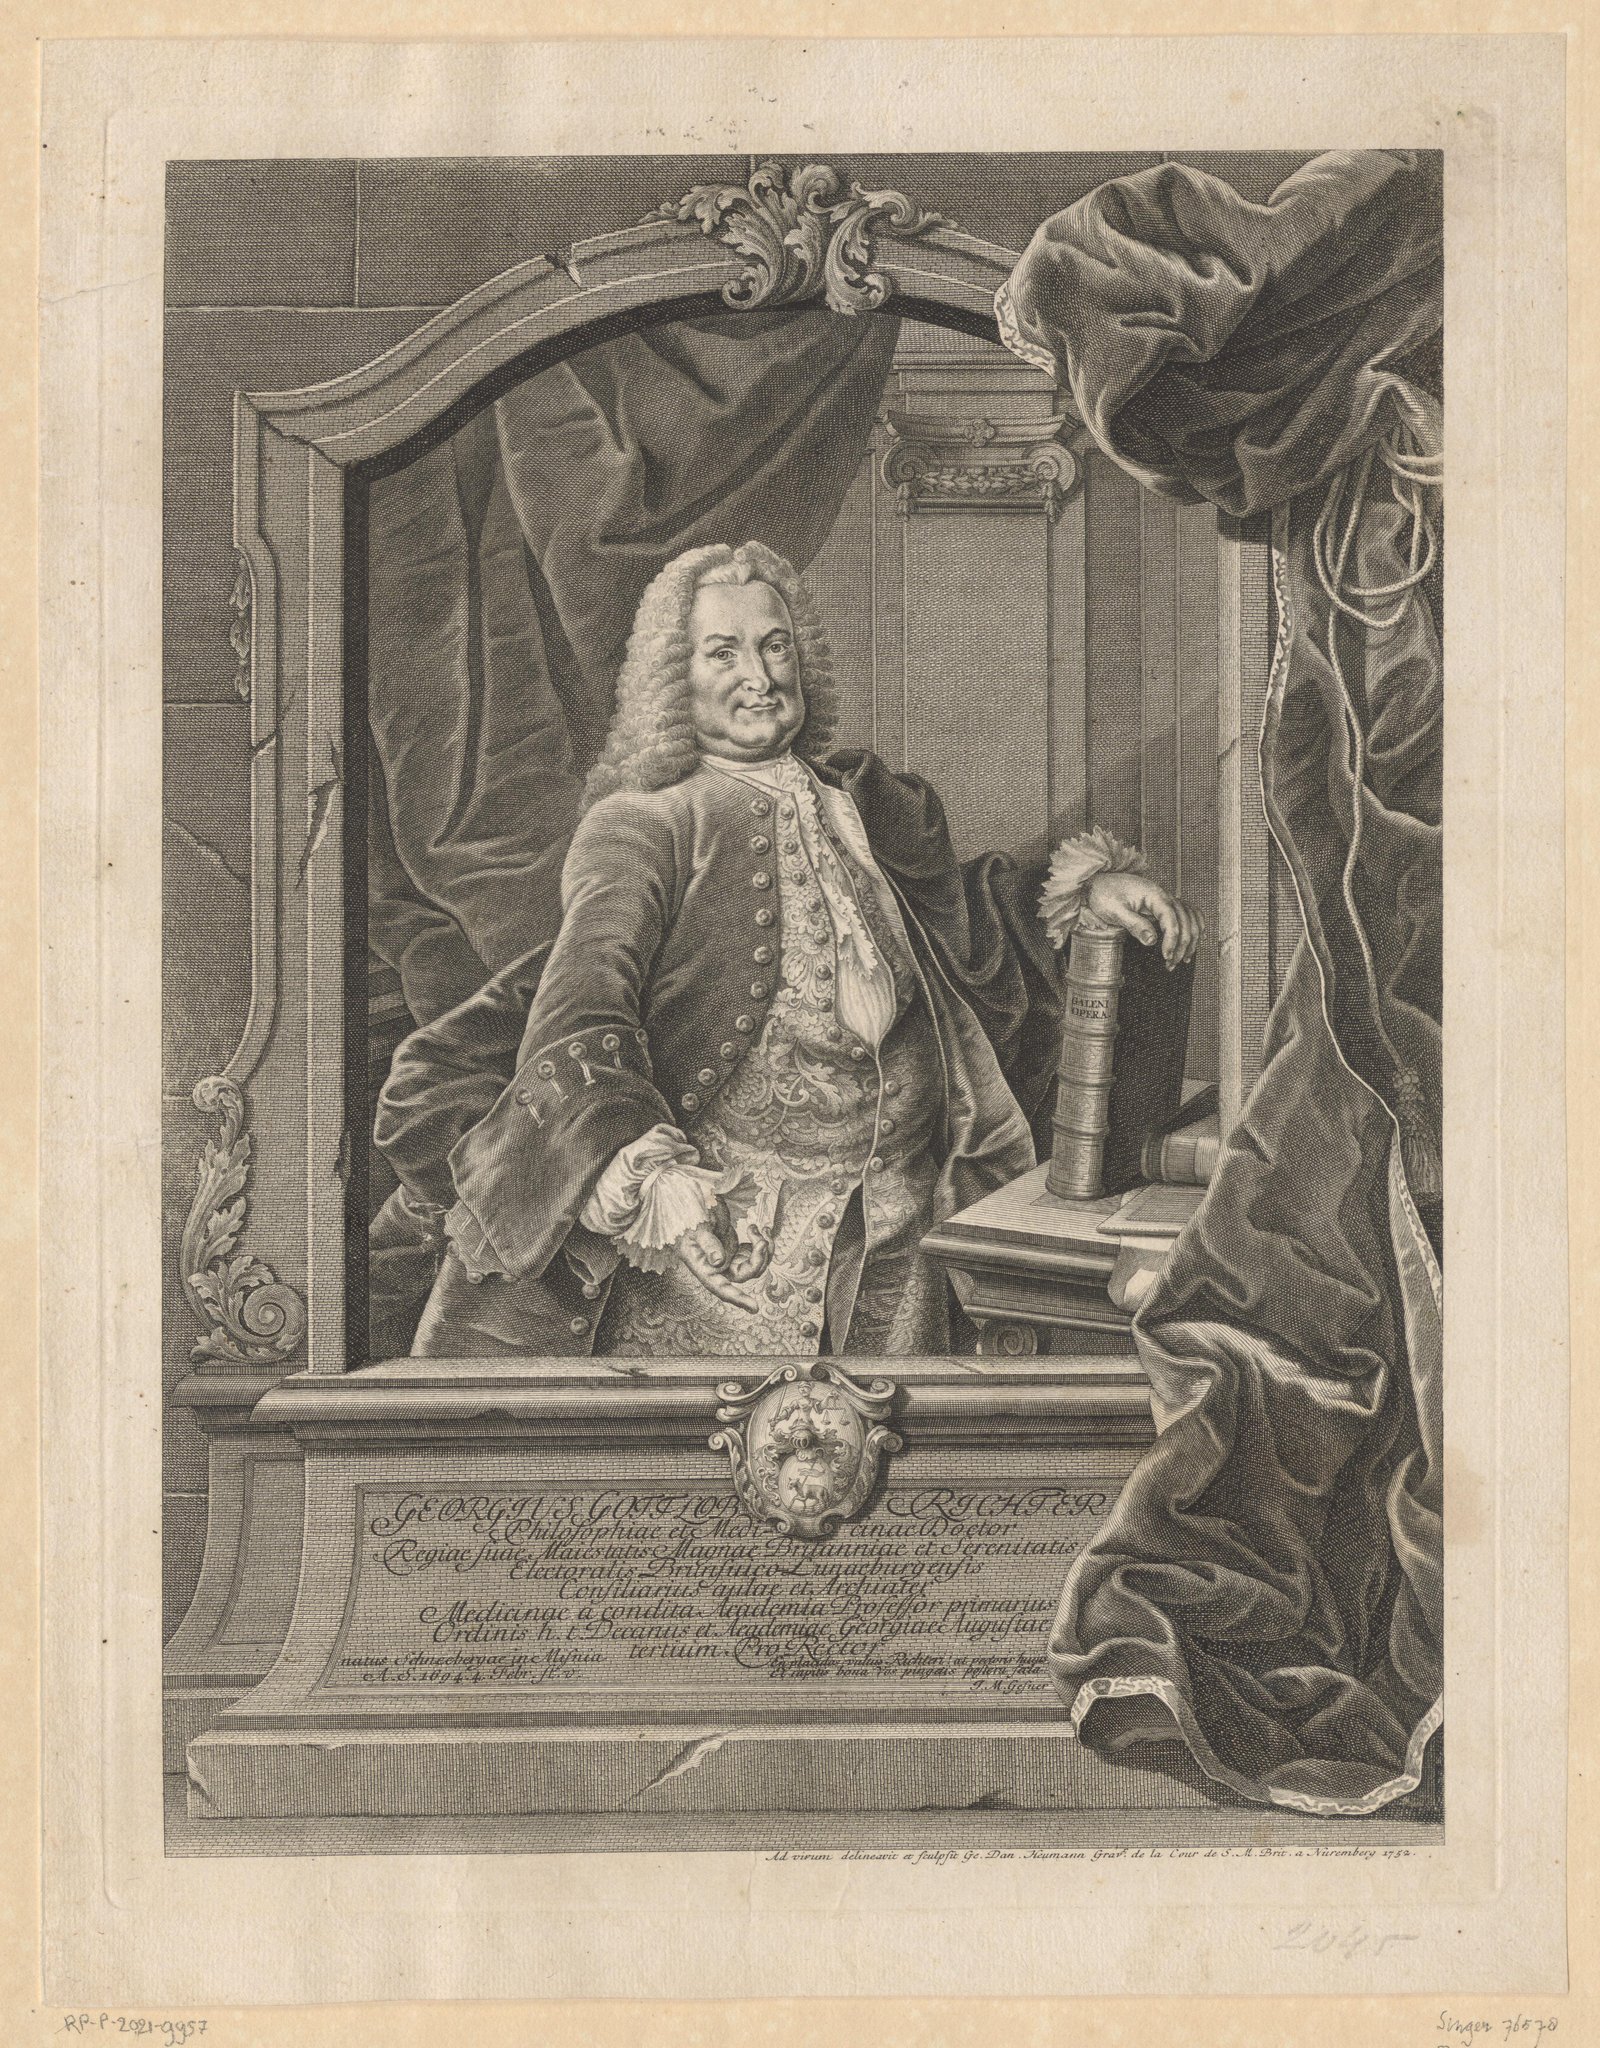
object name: print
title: Portret van Georg Gottlob Richter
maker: georg daniel heumann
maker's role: print maker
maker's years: 1691-1759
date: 1752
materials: paper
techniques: engraving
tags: historical persons, book, armorial bearing, heraldry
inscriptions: date